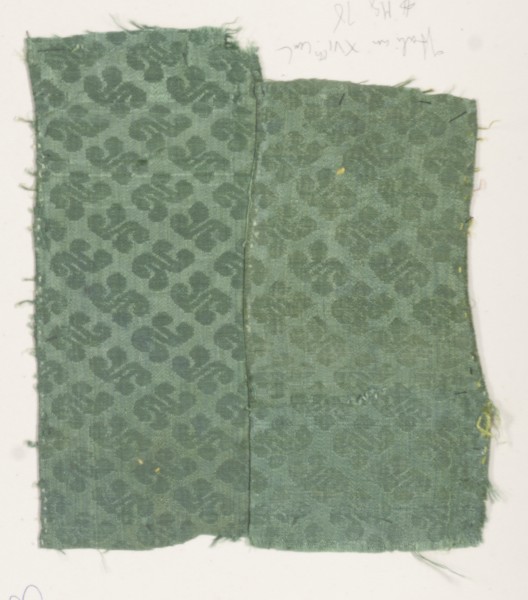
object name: fragment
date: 1501-1600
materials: silk